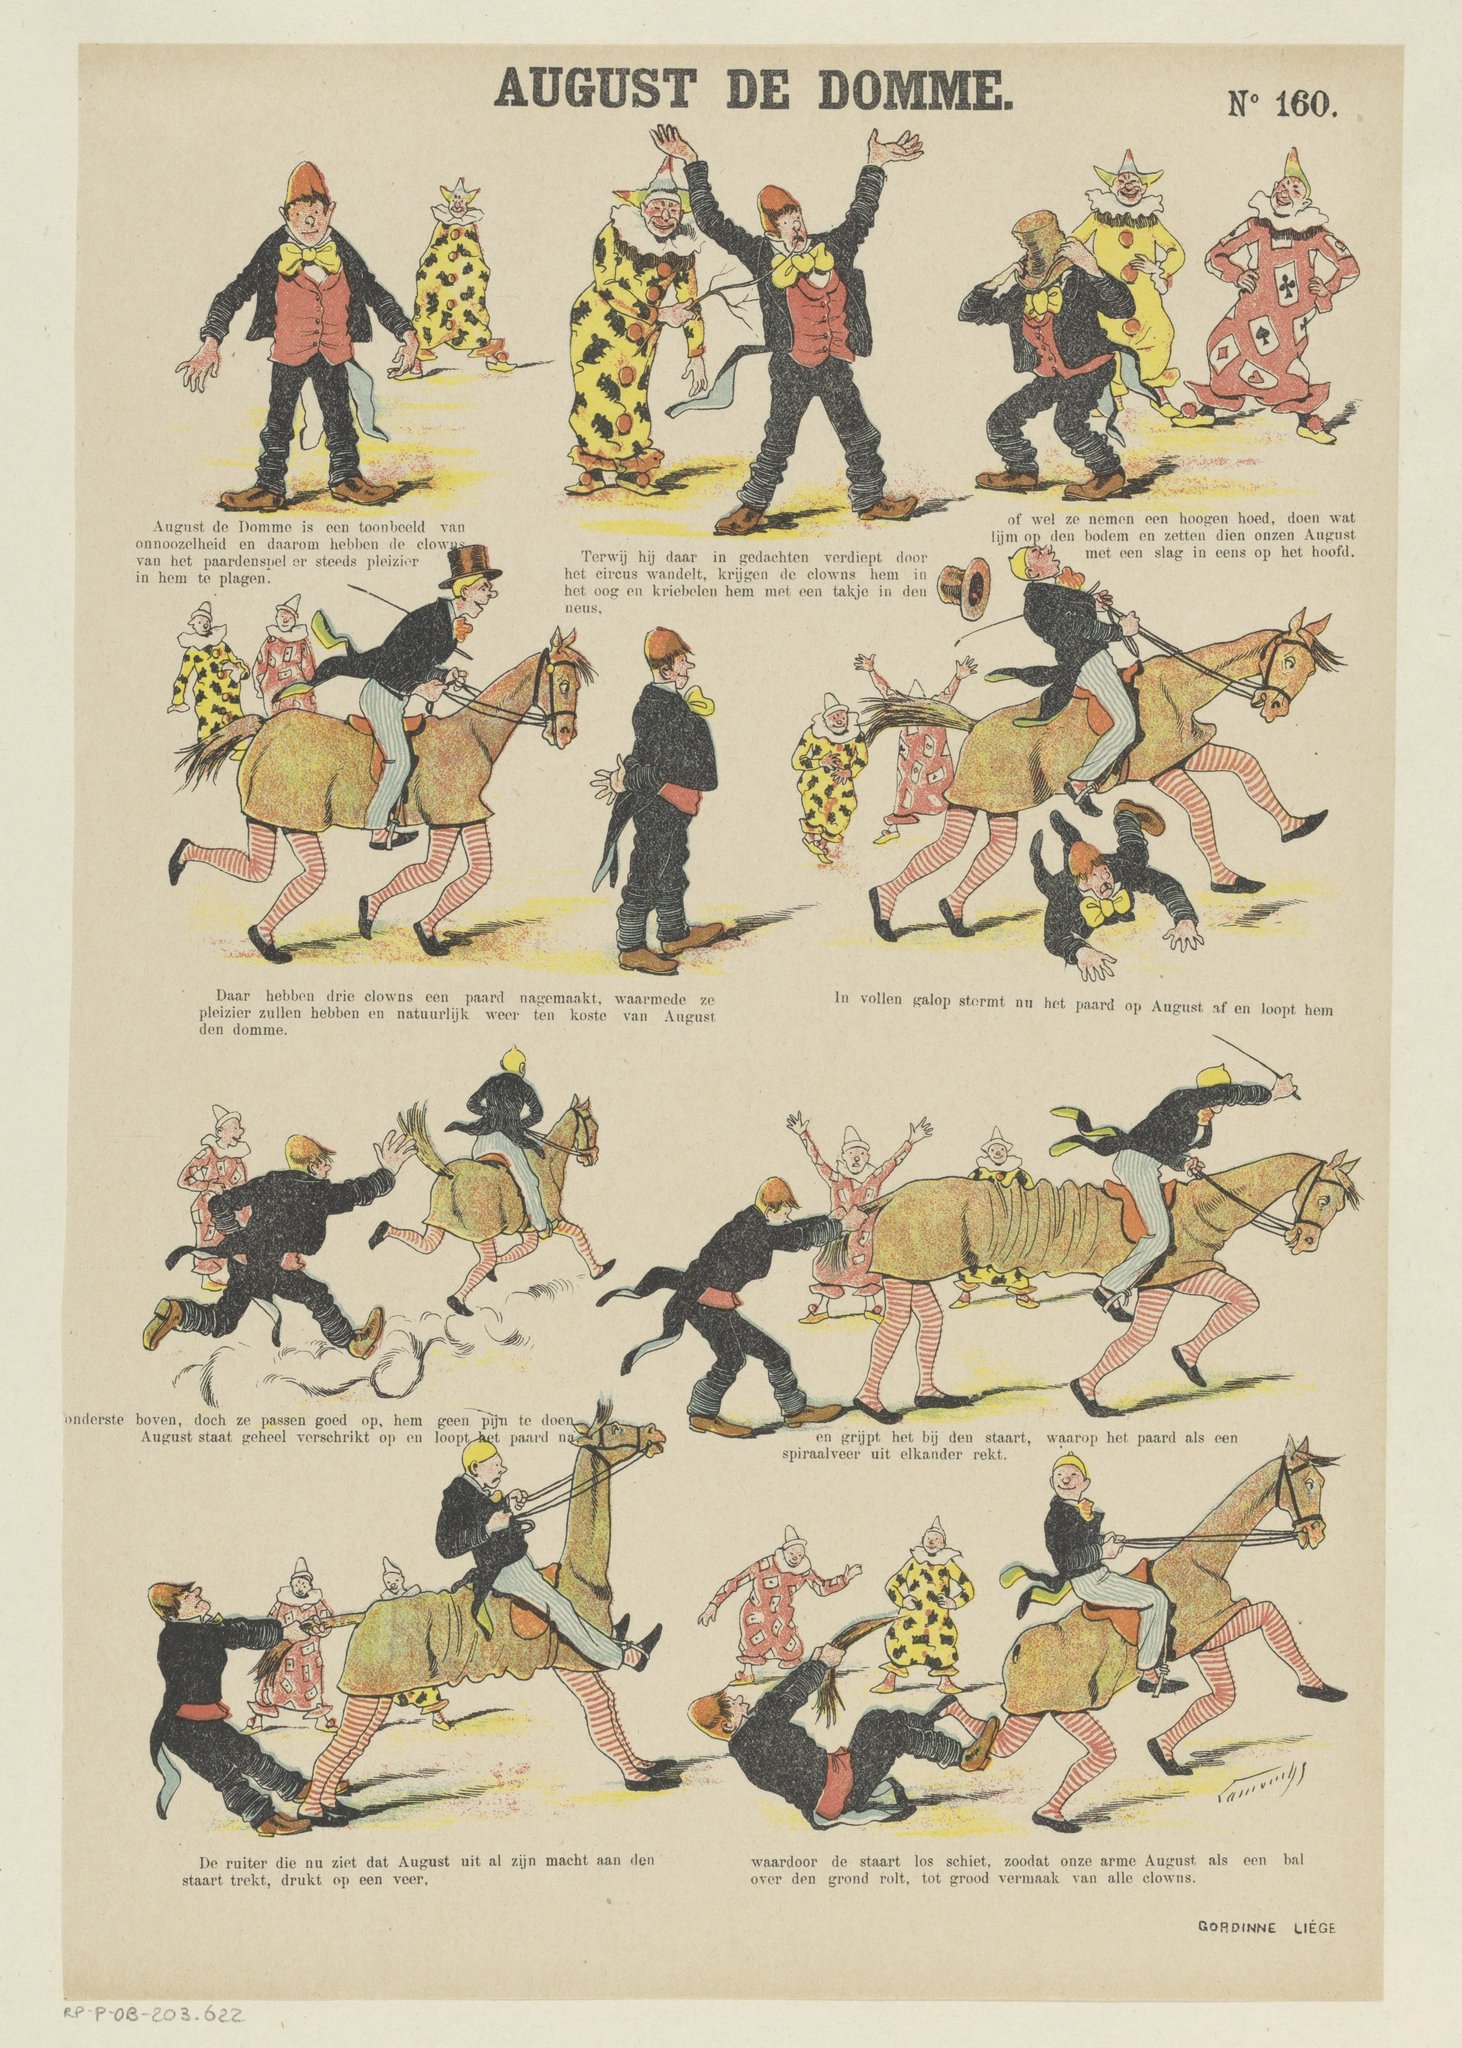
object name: print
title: August de domme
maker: lamouche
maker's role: print maker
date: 1894-1959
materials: paper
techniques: lithograph, letterpress printing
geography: liège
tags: circus, clown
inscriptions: collector's mark: Lugt 2760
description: Blad met 9 voorstellingen over circusclowns. Onder elke afbeelding een onderschrift. Genummerd rechtsboven: No 160.